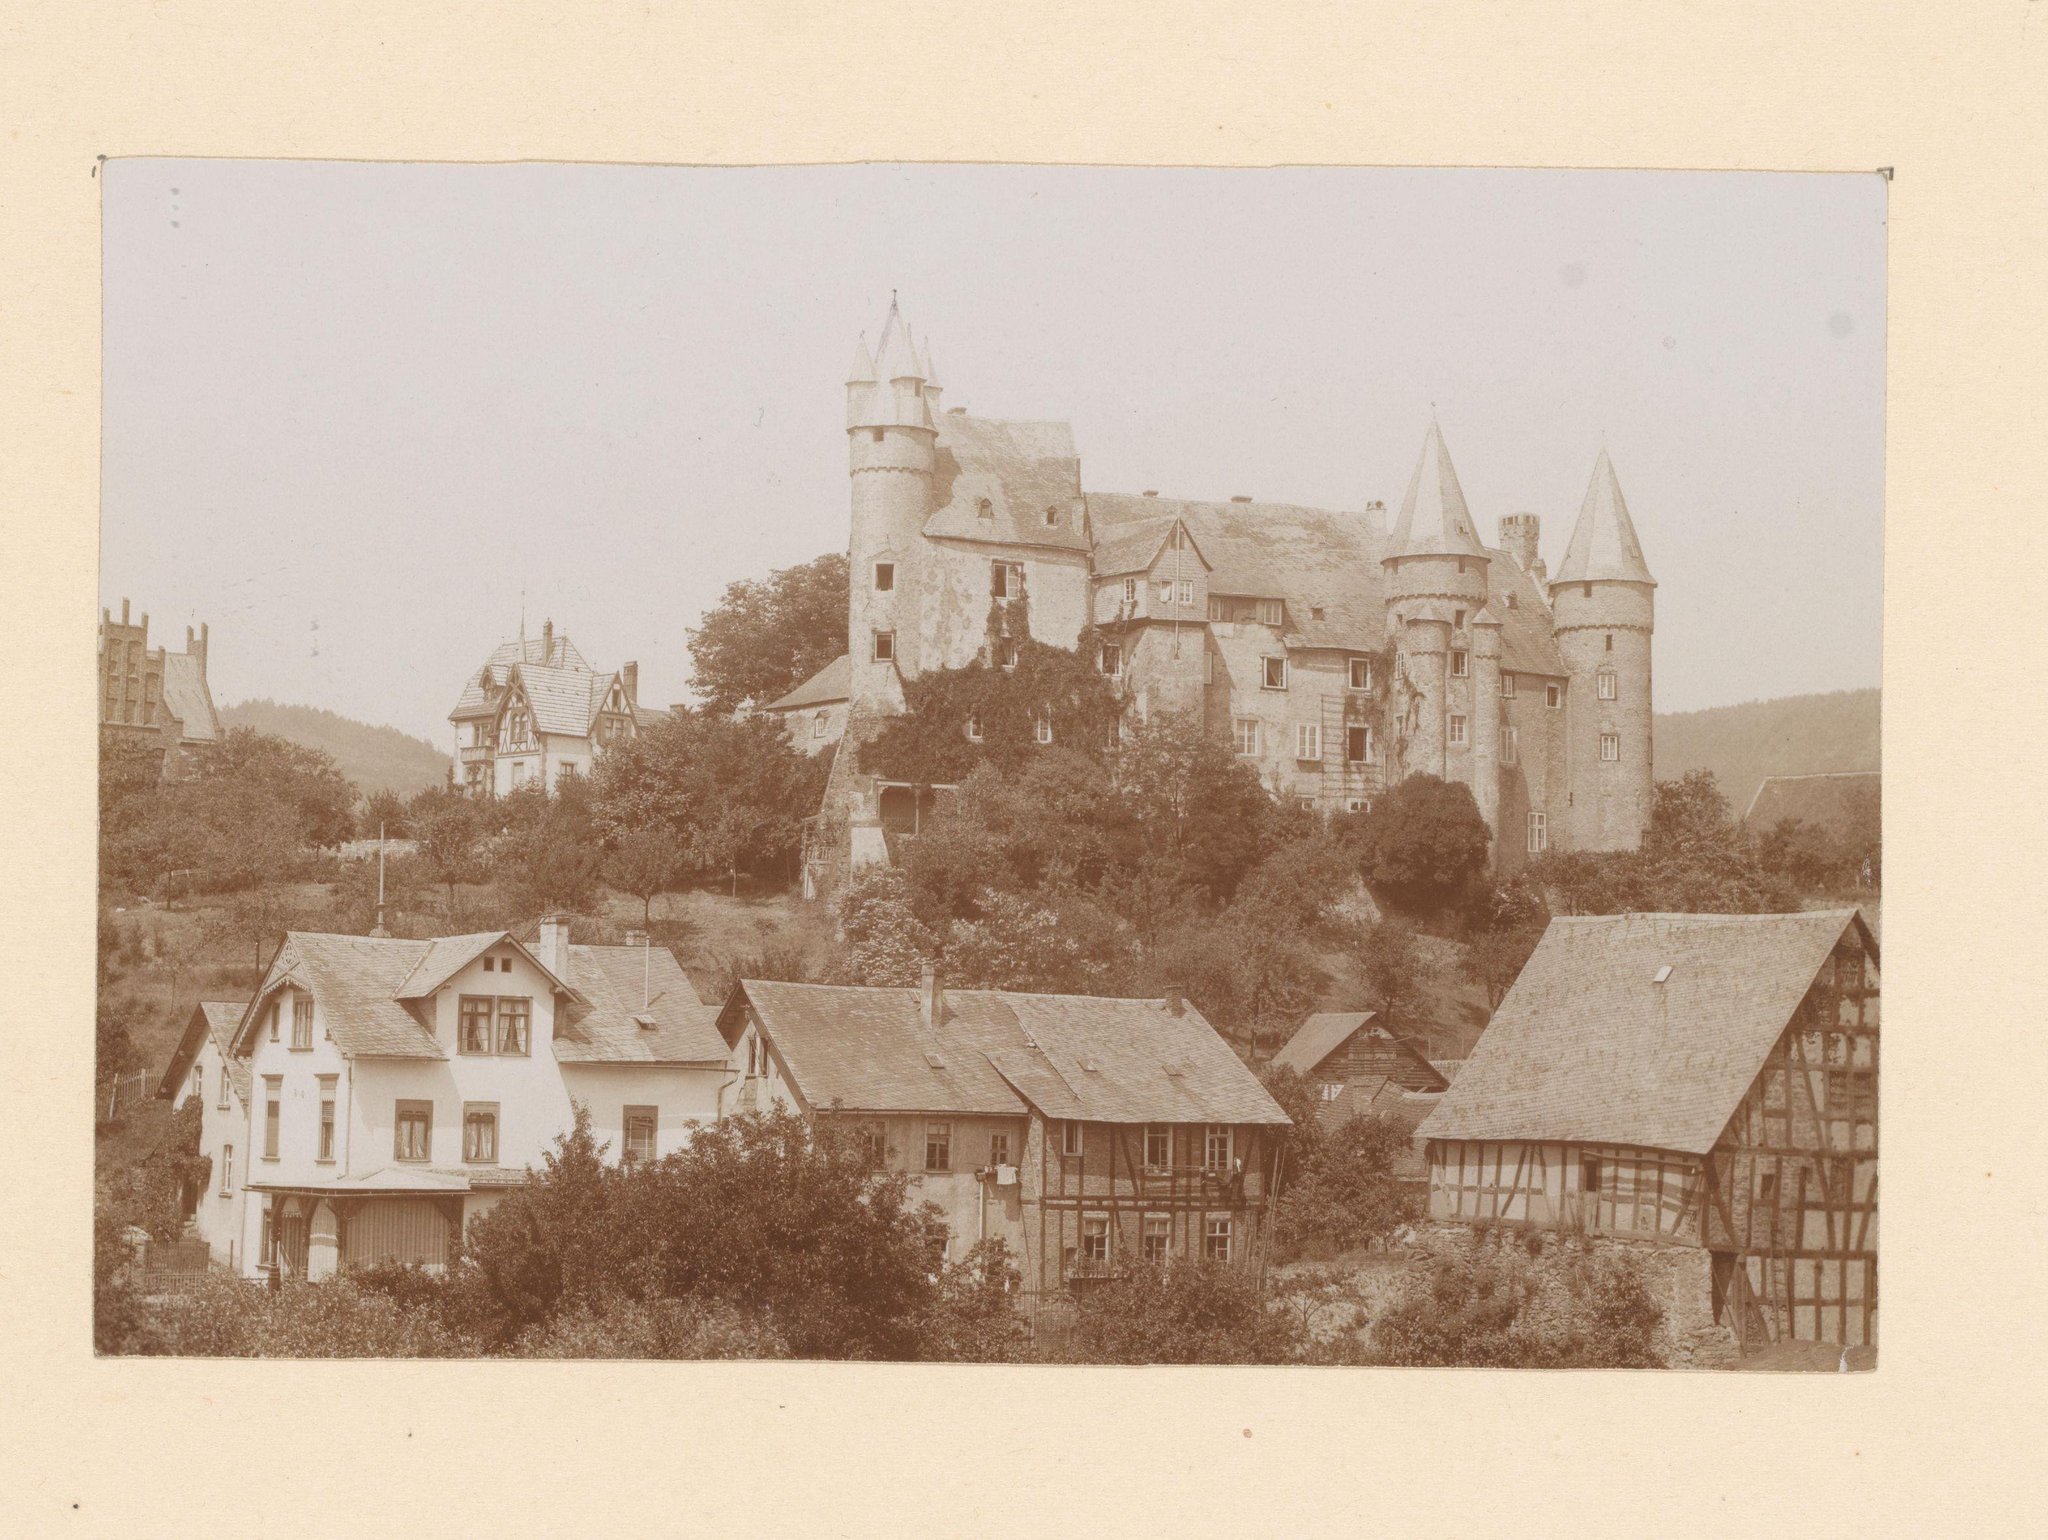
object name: photograph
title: Gezicht op slot Herborn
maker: Anonymous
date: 1880-1910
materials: paper, cardboard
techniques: collodion silver print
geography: herborn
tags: castle